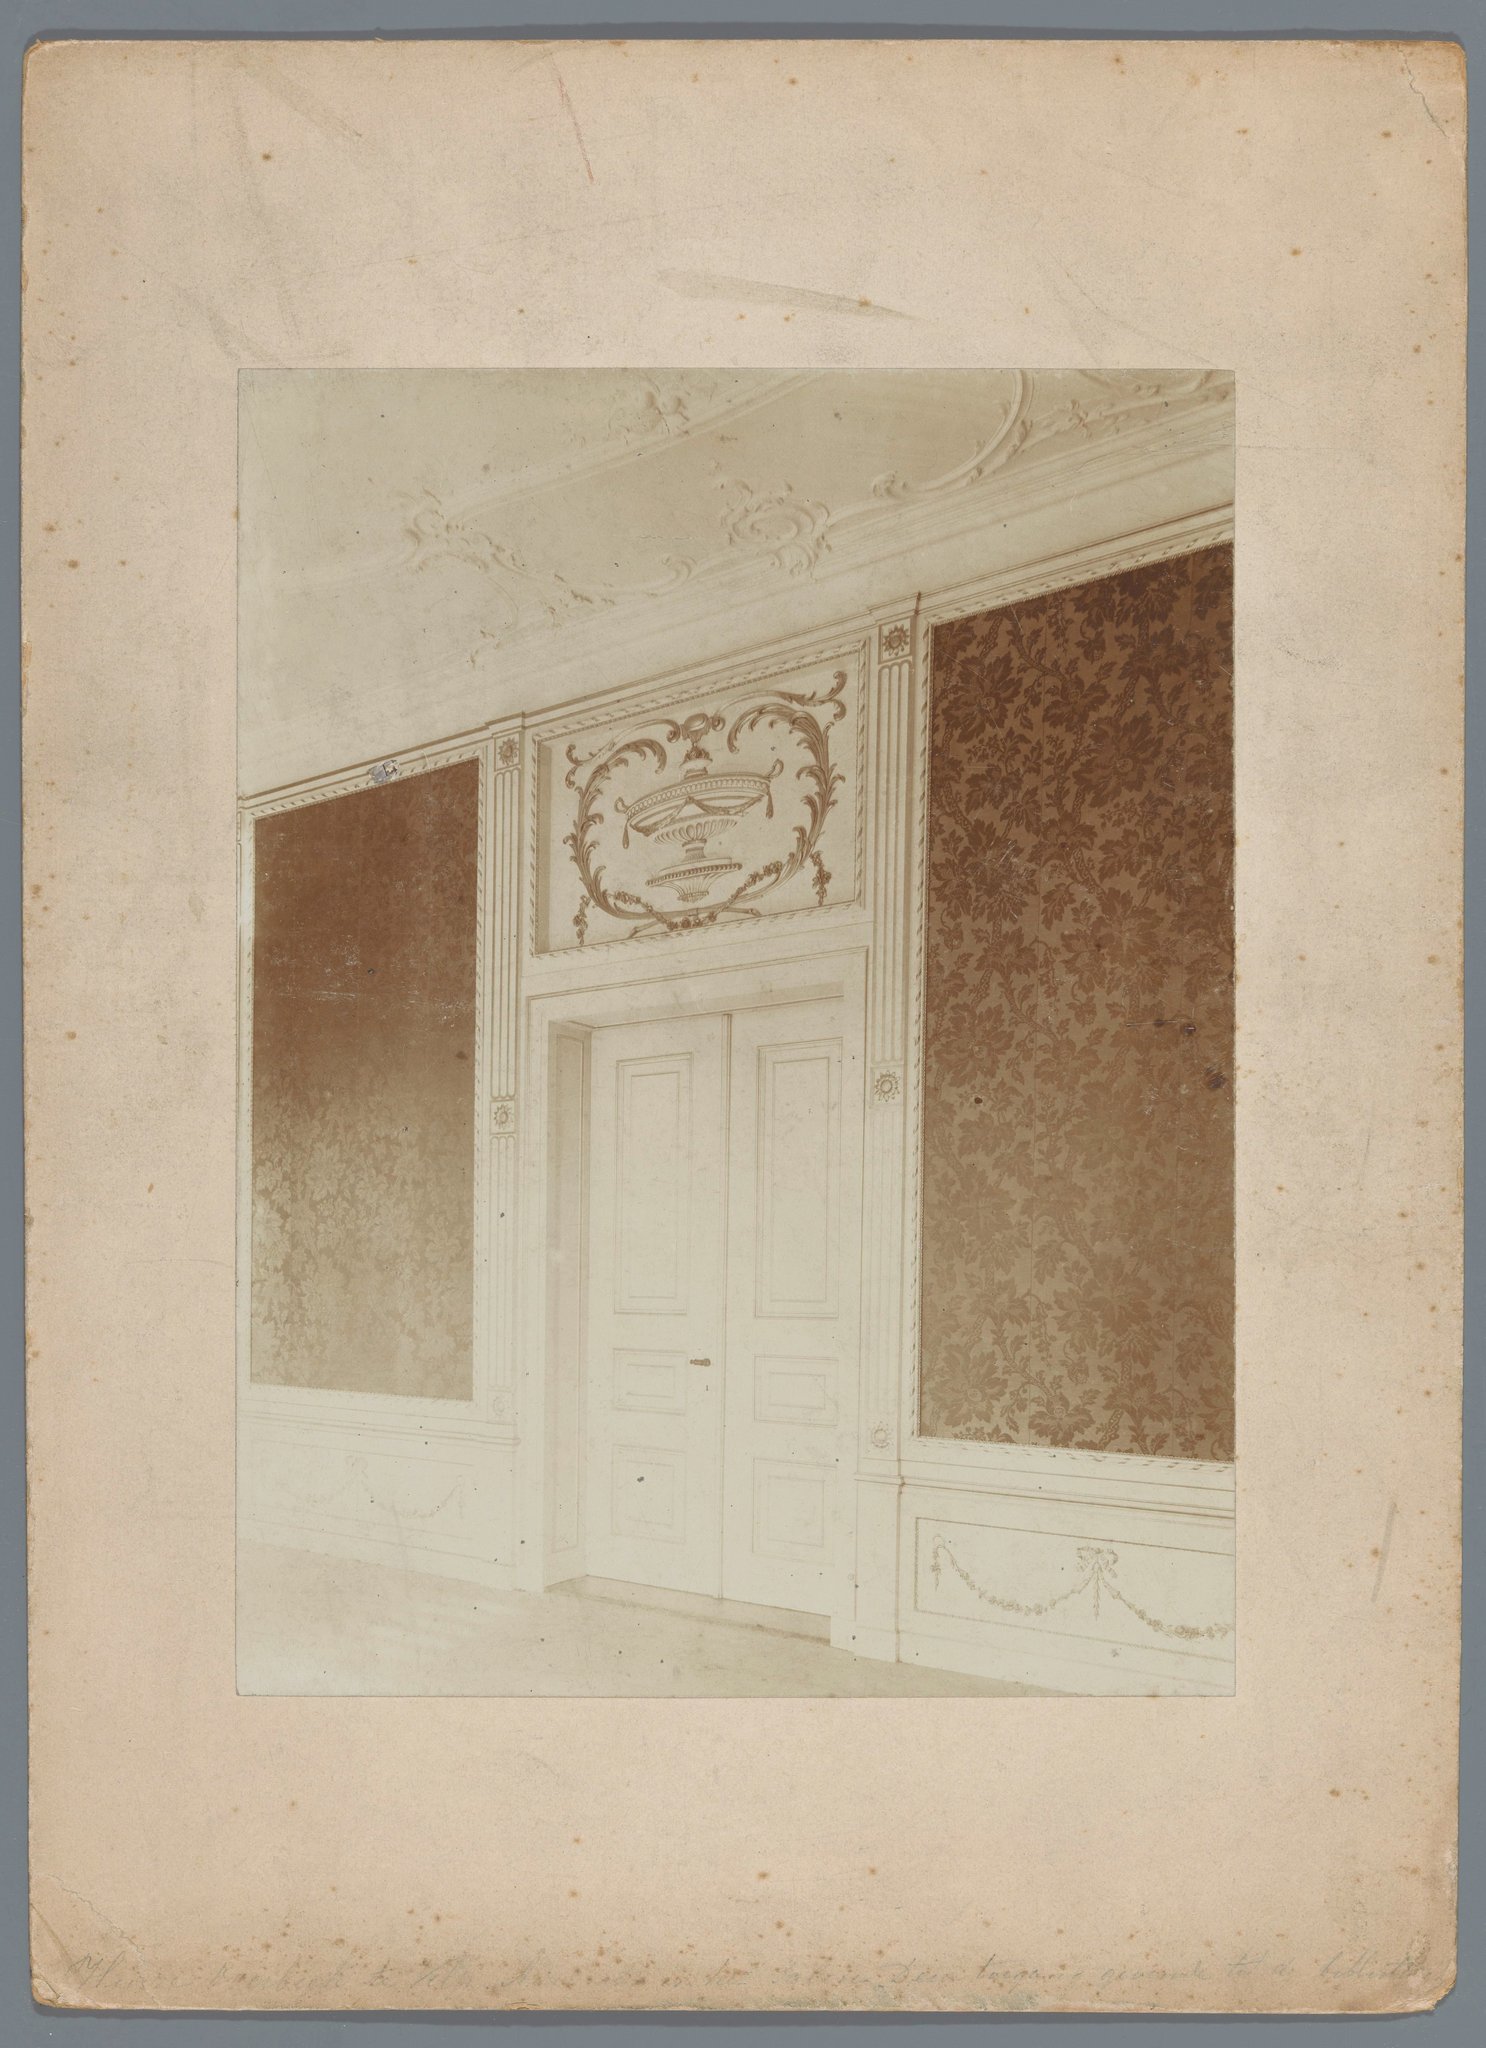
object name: photograph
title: Deur met reliëf in Huize Overbeek te Velp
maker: Anonymous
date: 1903-1906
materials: cardboard, photographic support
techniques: collodion silver print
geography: huize overbeek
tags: interior ~ representation of a building, closed door, sculpture (+ relief ~ sculpture)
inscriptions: annotation, inscription: ‘Velp (G.) Huize Overbeek Aanzicht in het salon. Deur naar de bibliotheek.’, inscription: ‘neg. no 16889 foto no 23911’